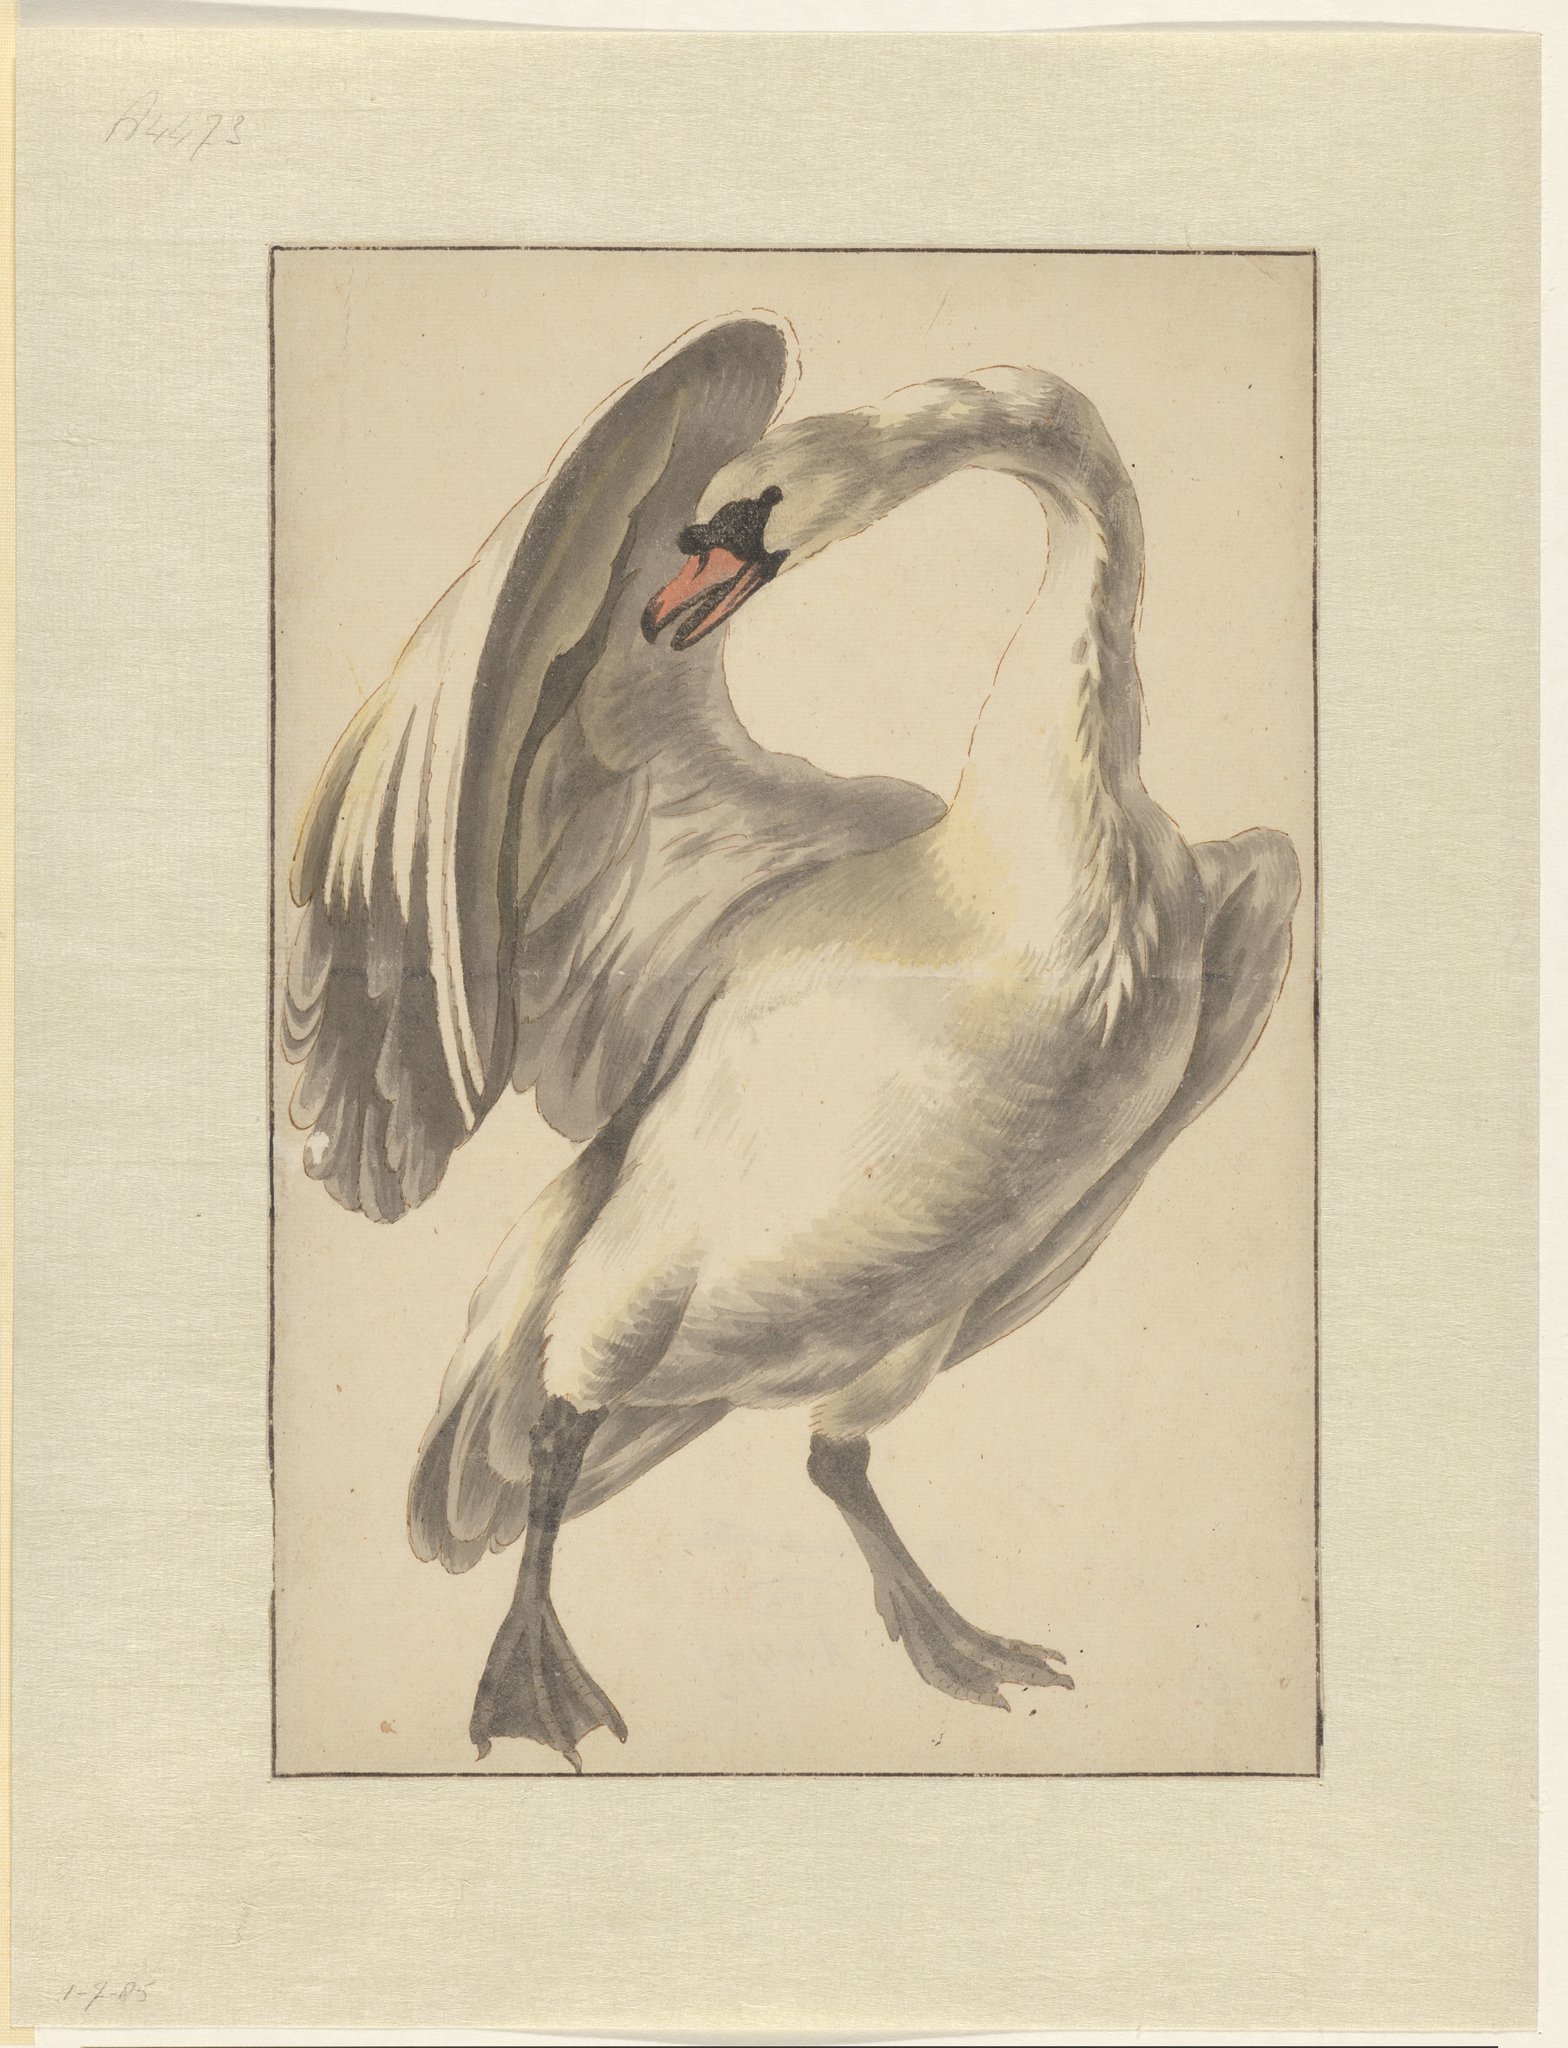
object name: drawing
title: Witte tamme zwaan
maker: melchior d hondecoeter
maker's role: draughtsman, painter, print maker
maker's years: 1636-1695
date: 1646-1695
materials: ink, paper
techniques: brush, pen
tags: water-birds: swan